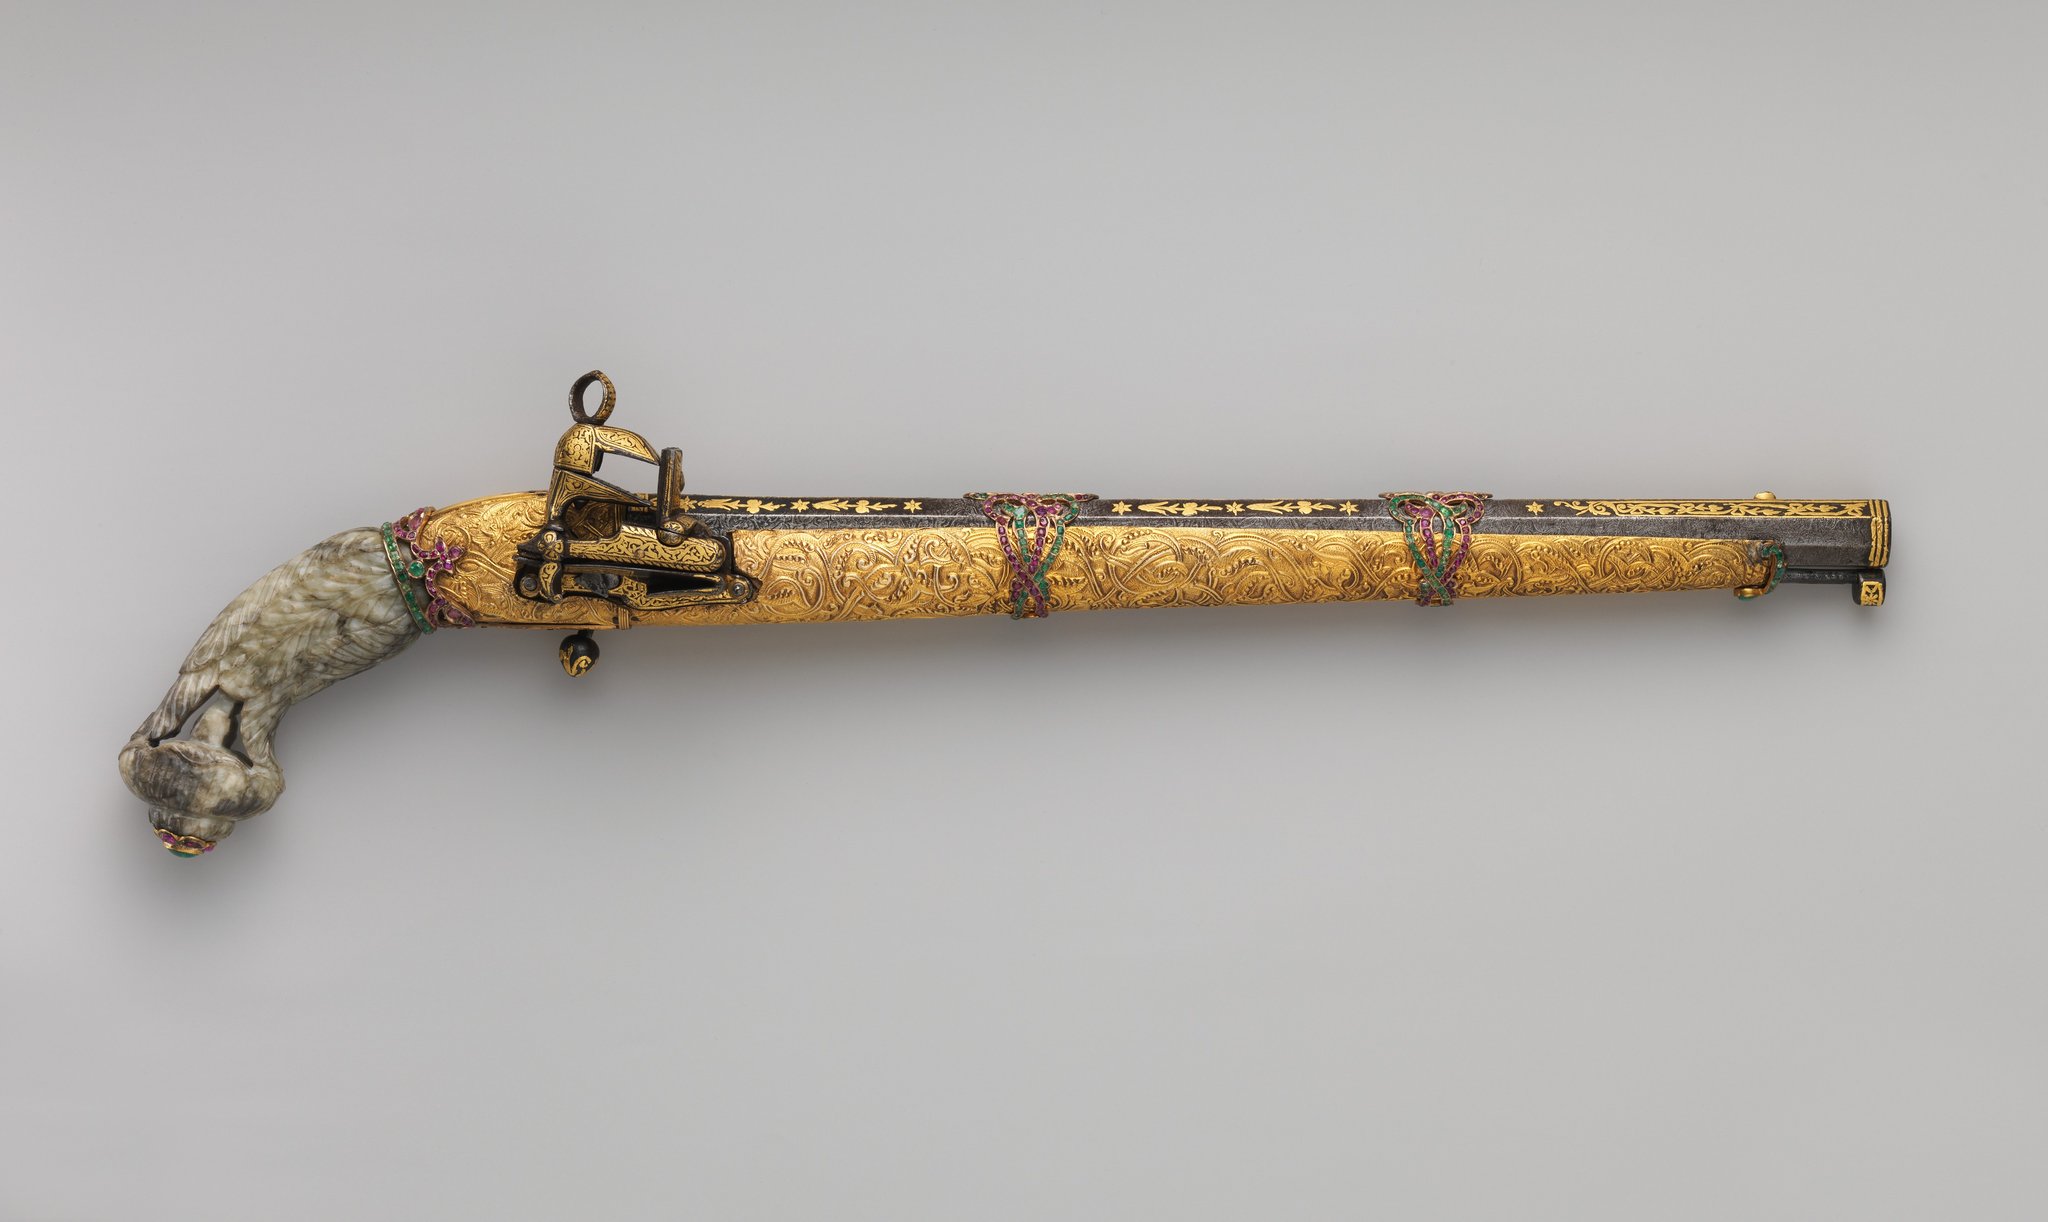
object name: miquelet pistol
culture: turkish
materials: gemstone, garnet, gold, jade, steel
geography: ottoman empire